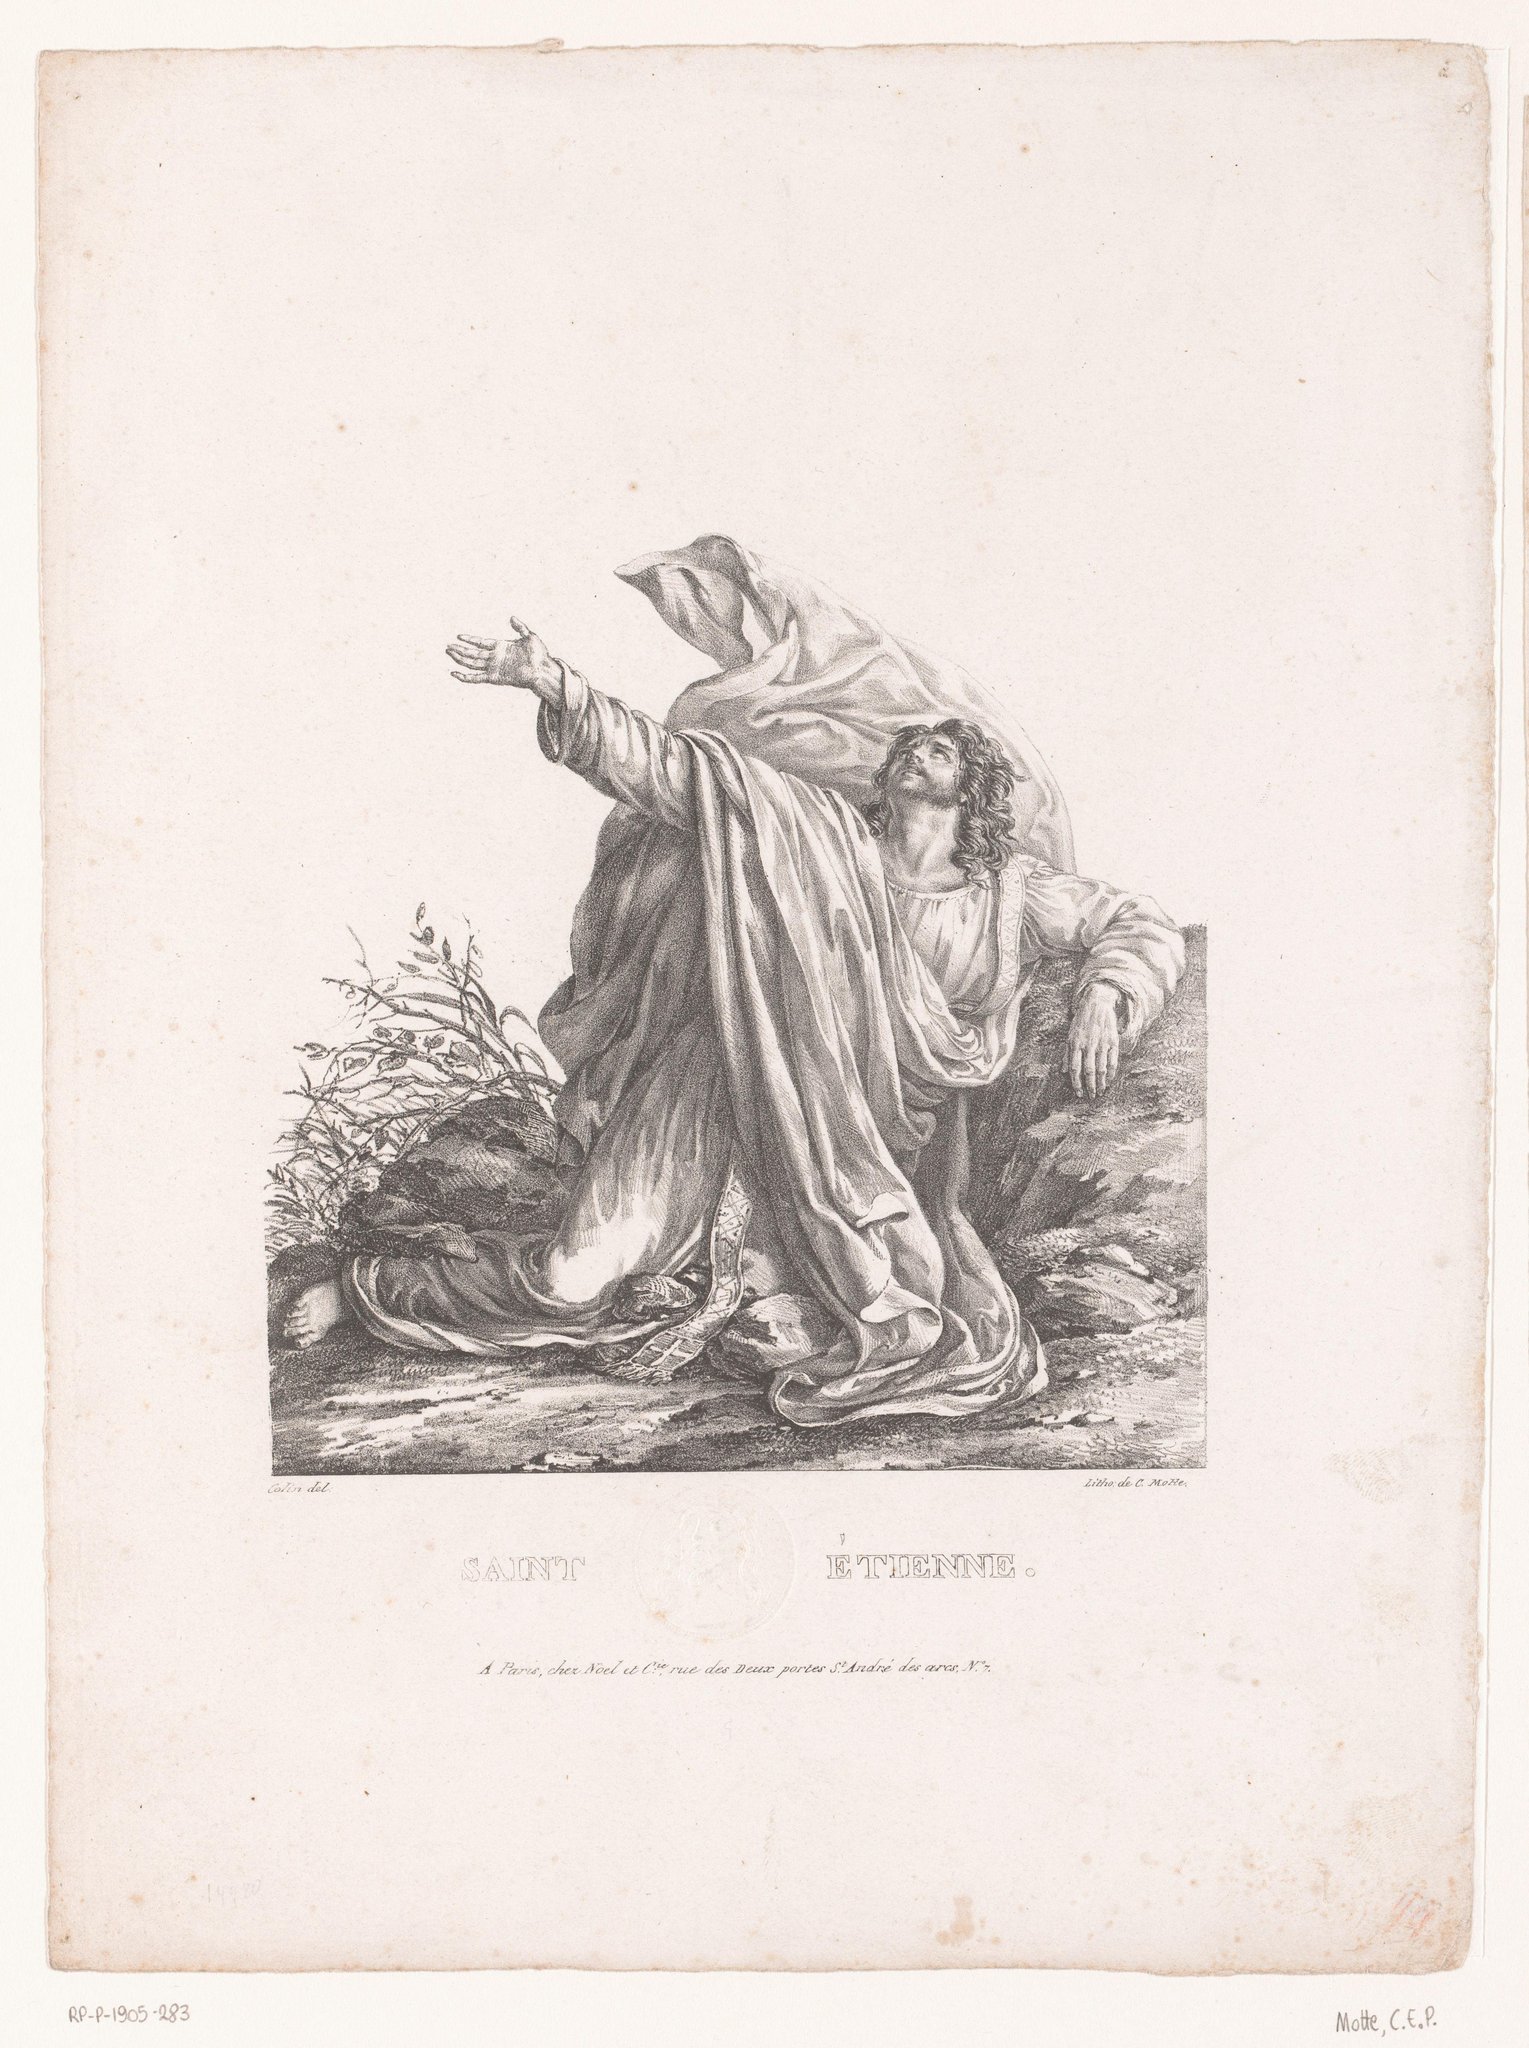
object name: print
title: Saint Étienne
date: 1817-1827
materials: paper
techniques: lithograph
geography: paris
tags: historical persons, saints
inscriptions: collector's mark: Lugt 1337, collector's mark: Lugt 2228, check stamp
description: Prent ook gebruikt in een Album Religieux uitgegeven door Noël.